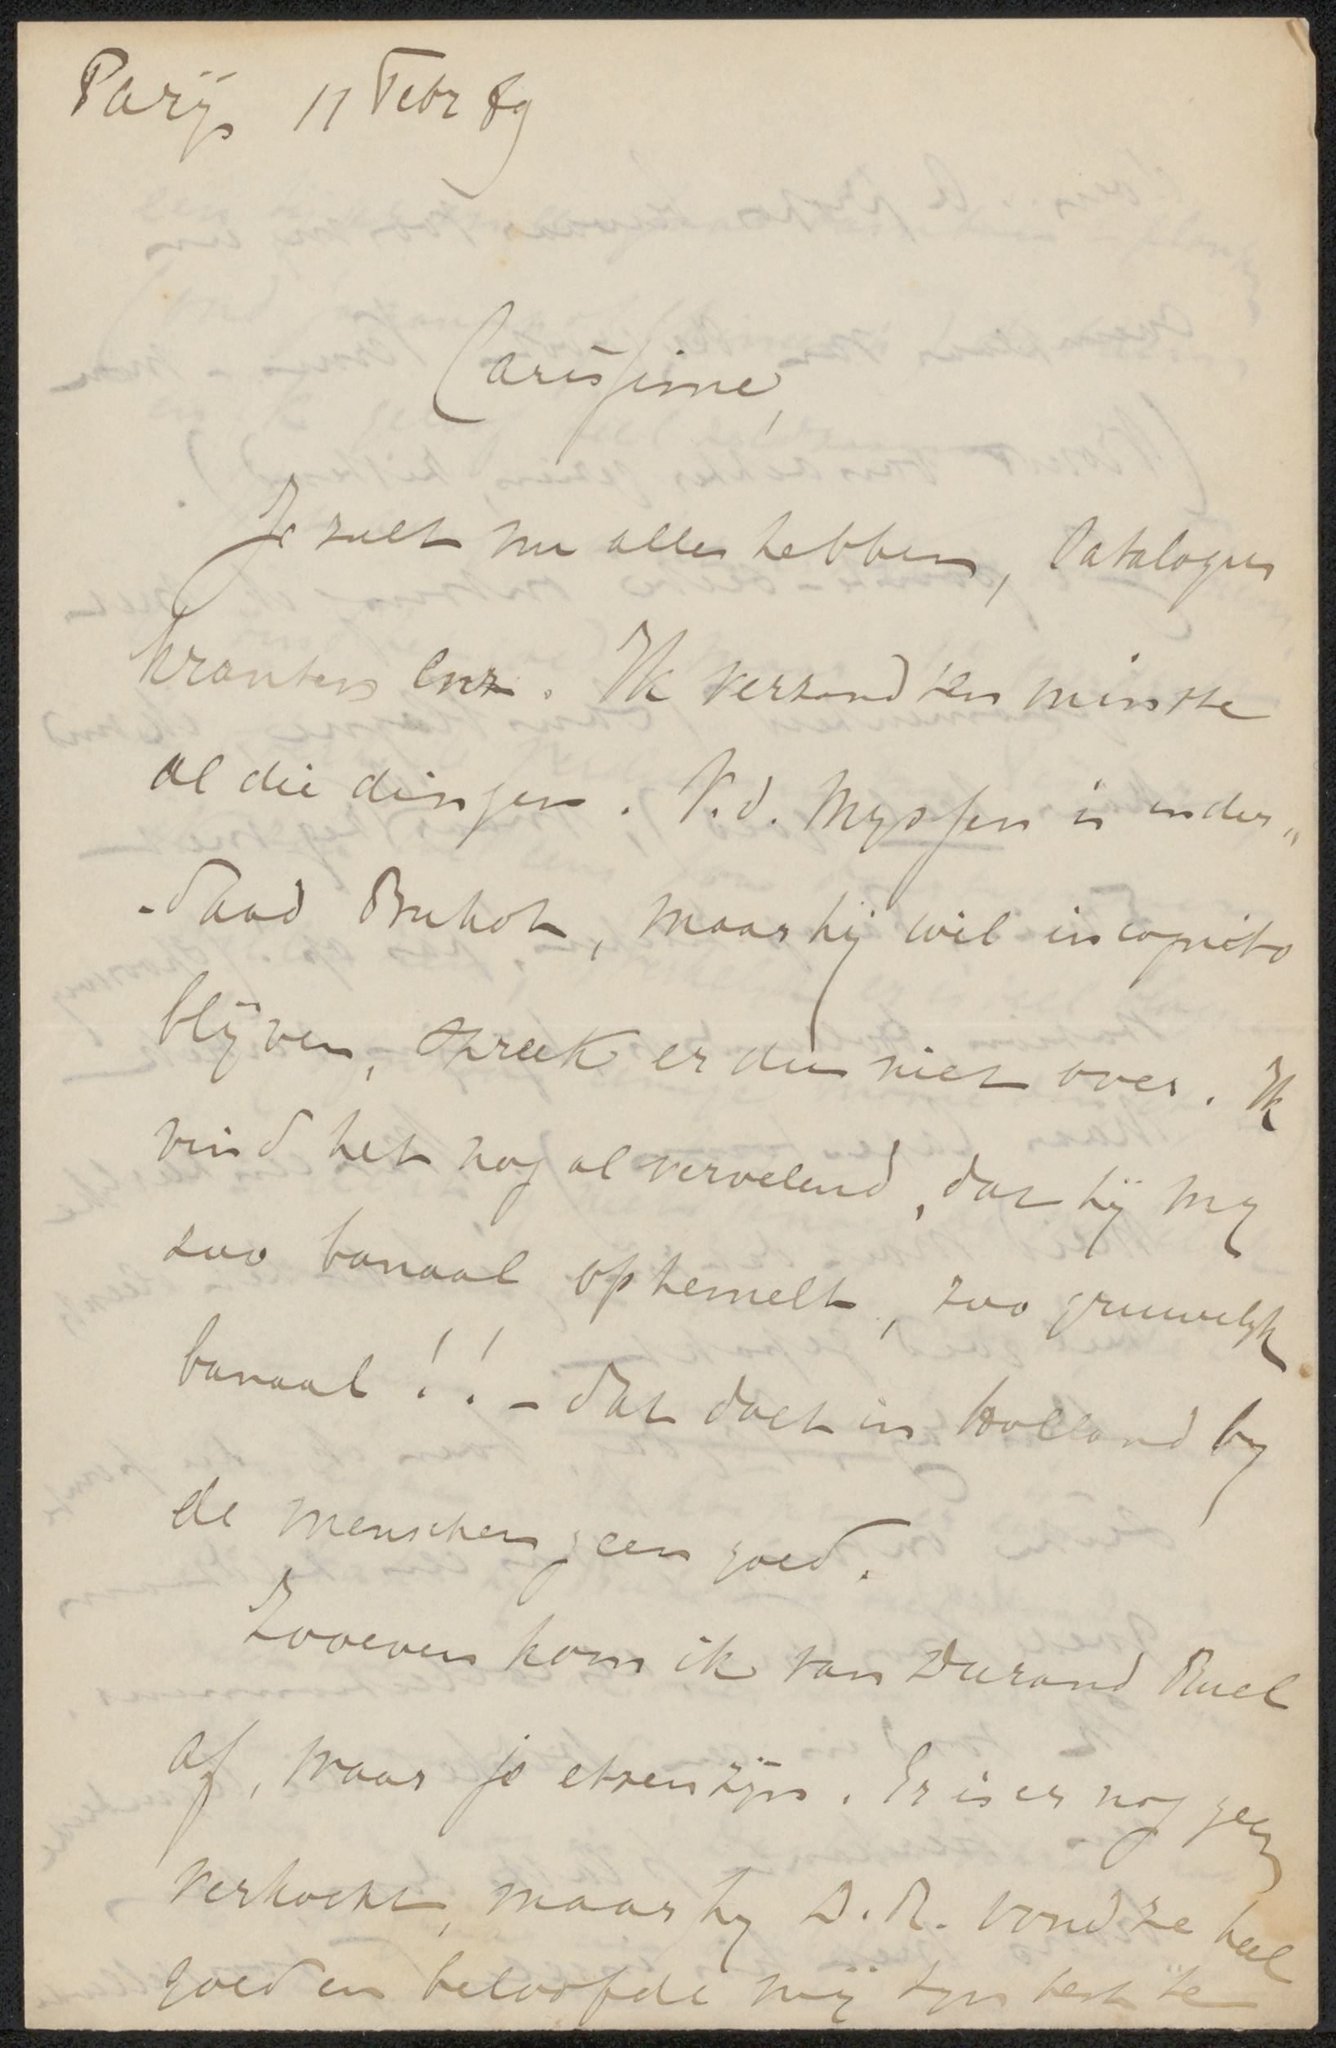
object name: letter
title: Brief aan Philip Zilcken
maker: adriaan pit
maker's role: print maker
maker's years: 1860-1944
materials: ink, paper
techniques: pen, writing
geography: paris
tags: lille, émile bernard, marinus van der maarel, félix hilaire buhot, paris, painter, print maker, lucien pissarro, félix fénéon, draughtsman, philip zilcken, the graphic arts, art collecting, printed matter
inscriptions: collector's mark: ‘RPK’